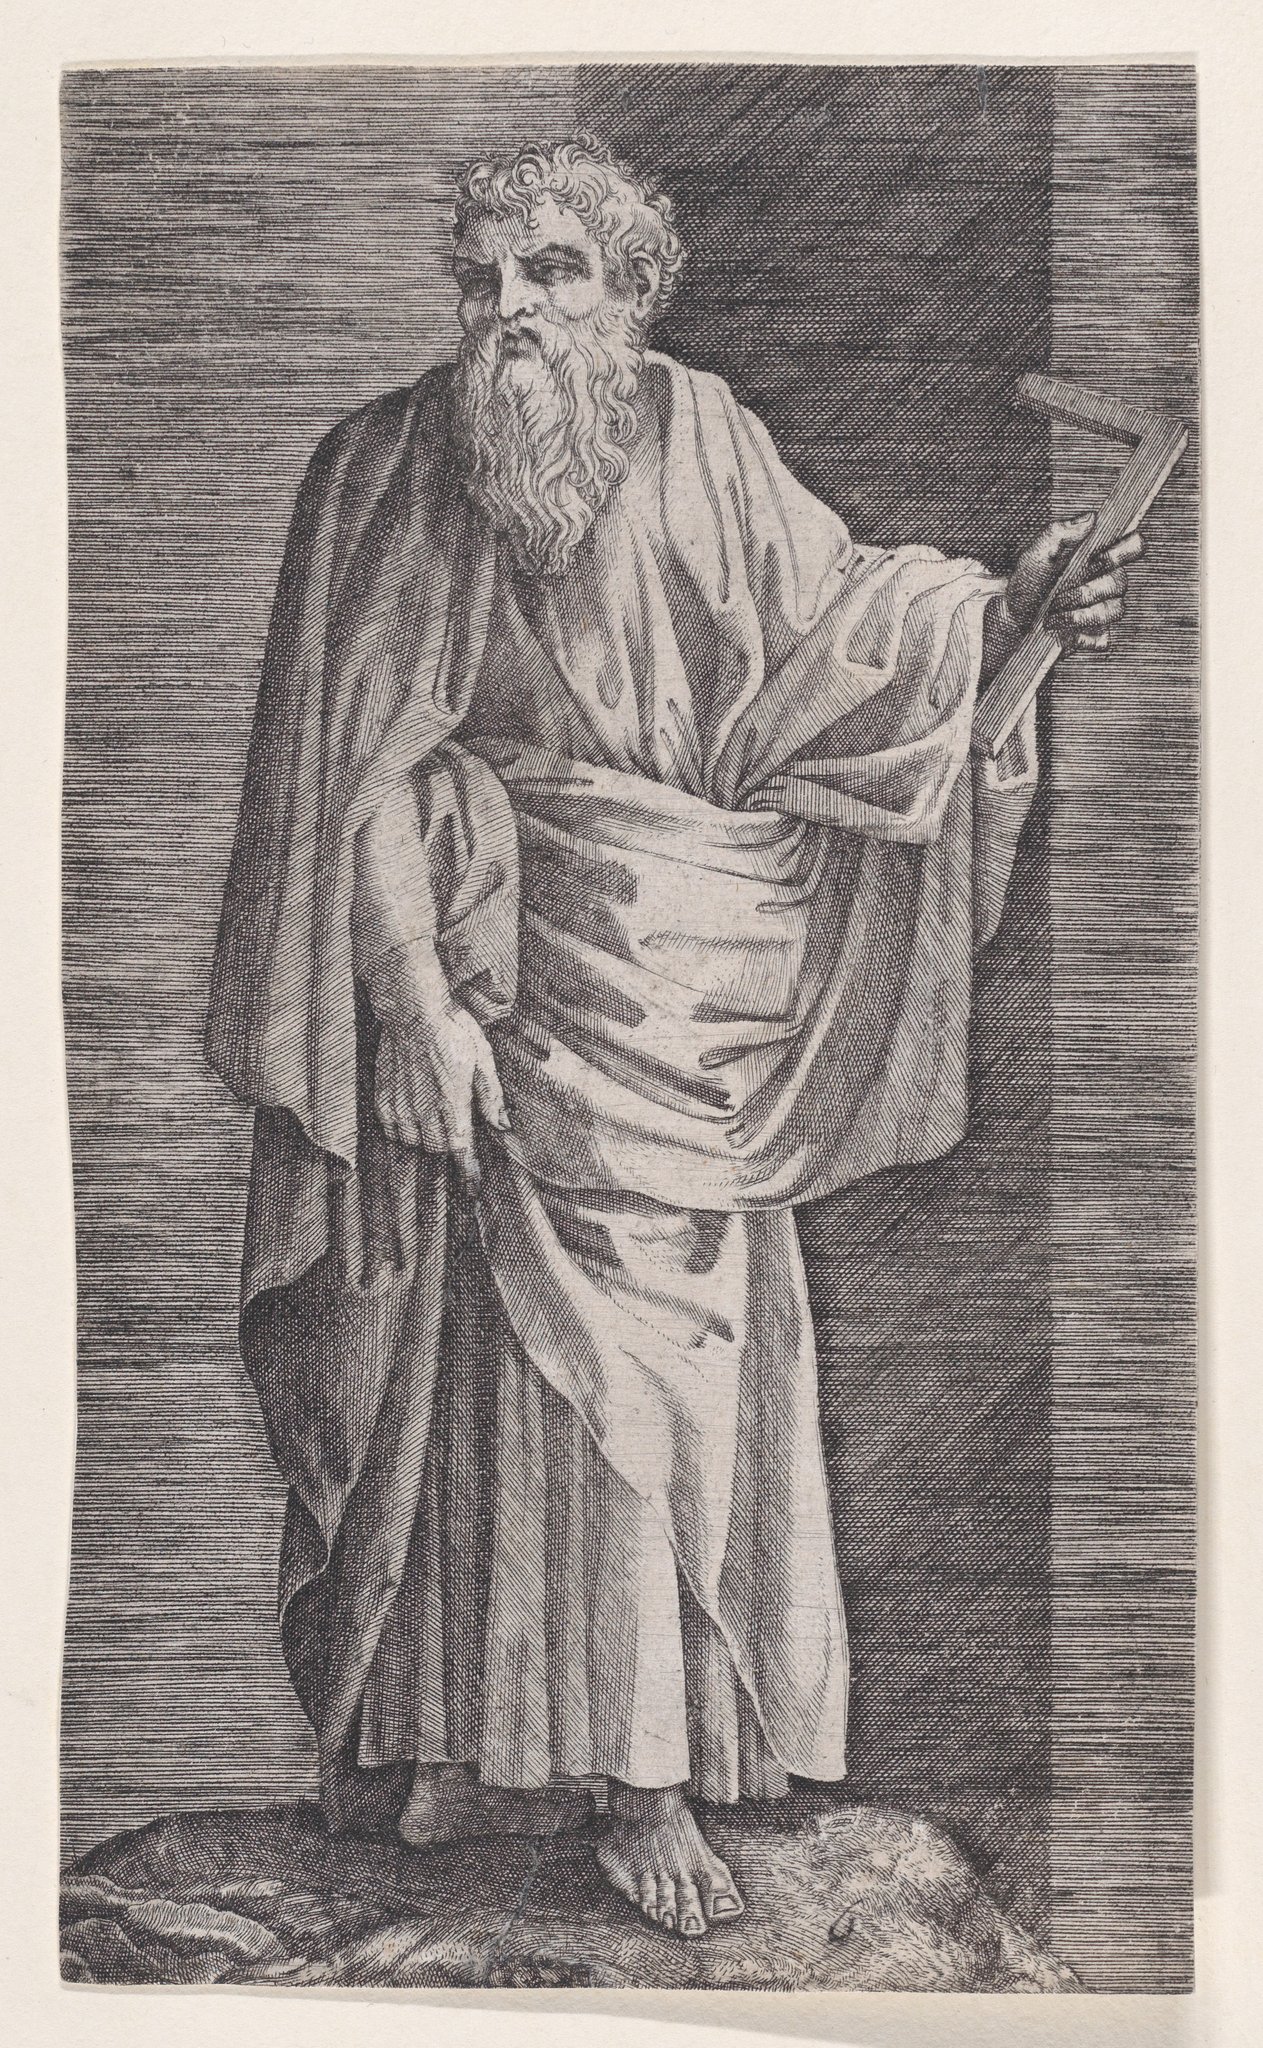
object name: print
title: St. Matthew, from "Christ and the Apostles"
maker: lambert suavius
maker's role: artist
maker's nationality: netherlandish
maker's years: 1510-1576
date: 1530-1576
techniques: backing, engraving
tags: men,saint matthew